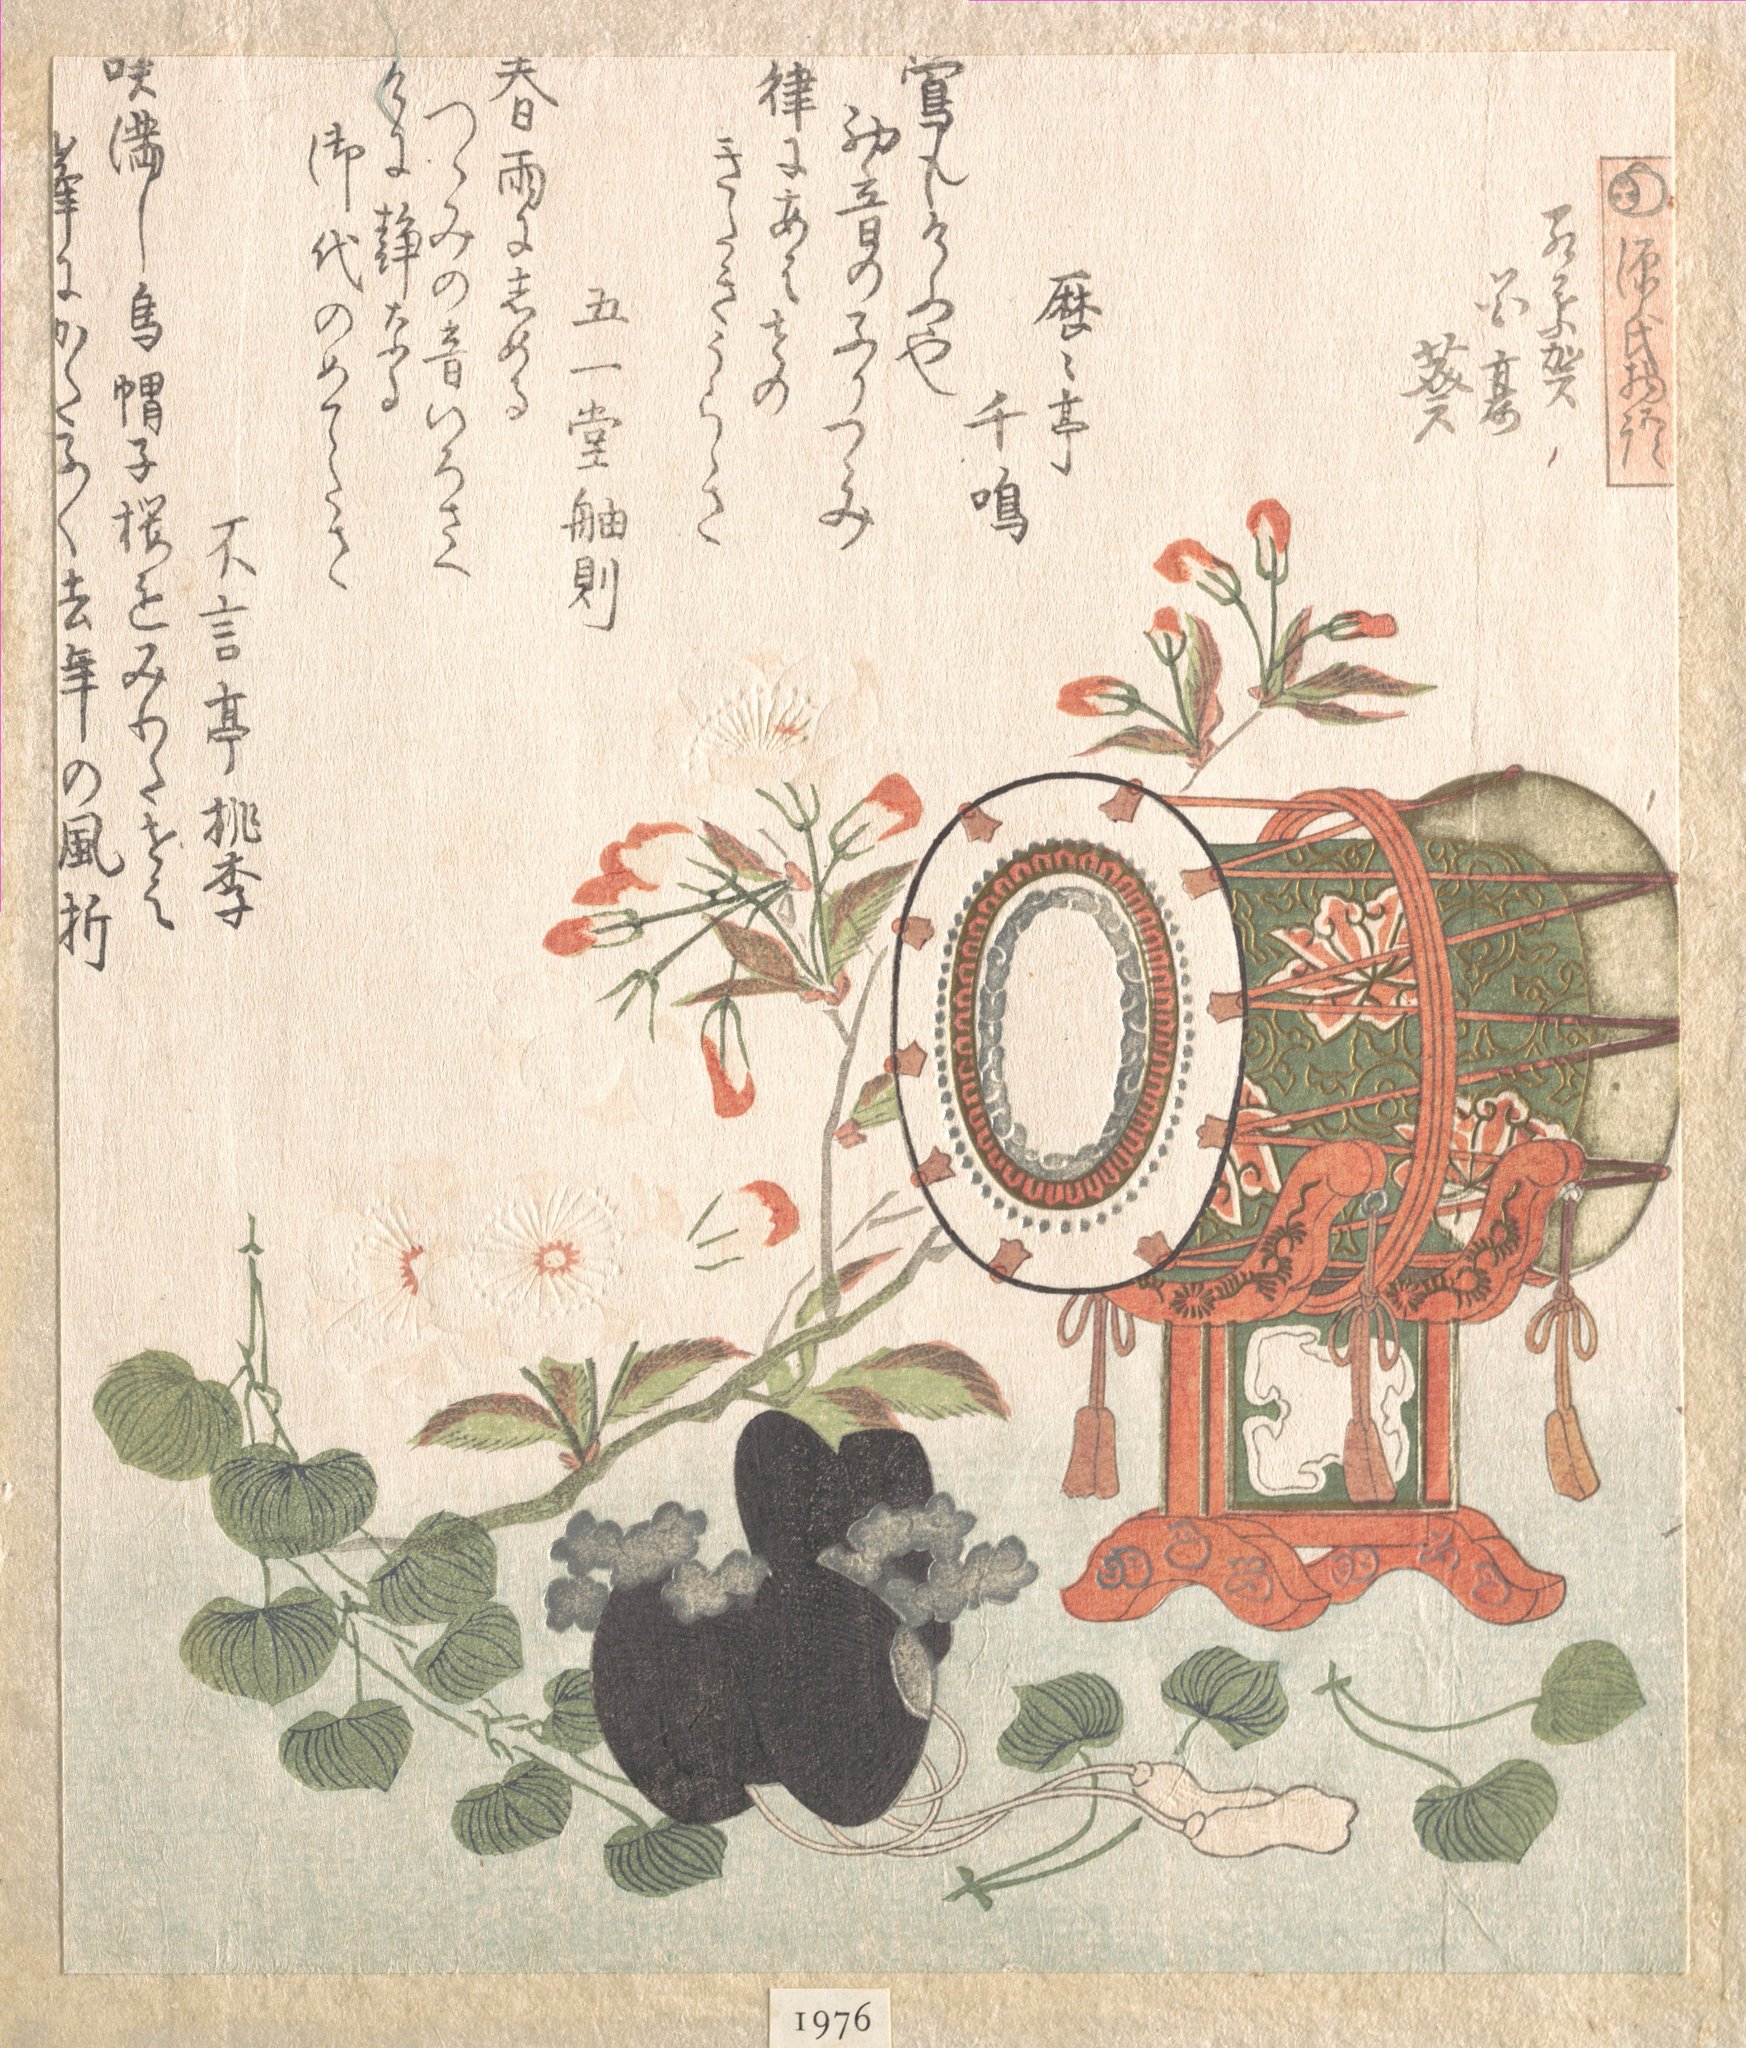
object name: print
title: Aoi Plant, Cherry Blossoms, Drum and Eboshi Hat Representing the "Aoi" Chapter of The Story of Genji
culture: japanese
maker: ryūryūkyo shinsai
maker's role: artist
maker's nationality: japanese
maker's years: 1799-1823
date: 1801-1900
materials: ink, paper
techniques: surimono, woodblock print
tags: drums,flowers,plants